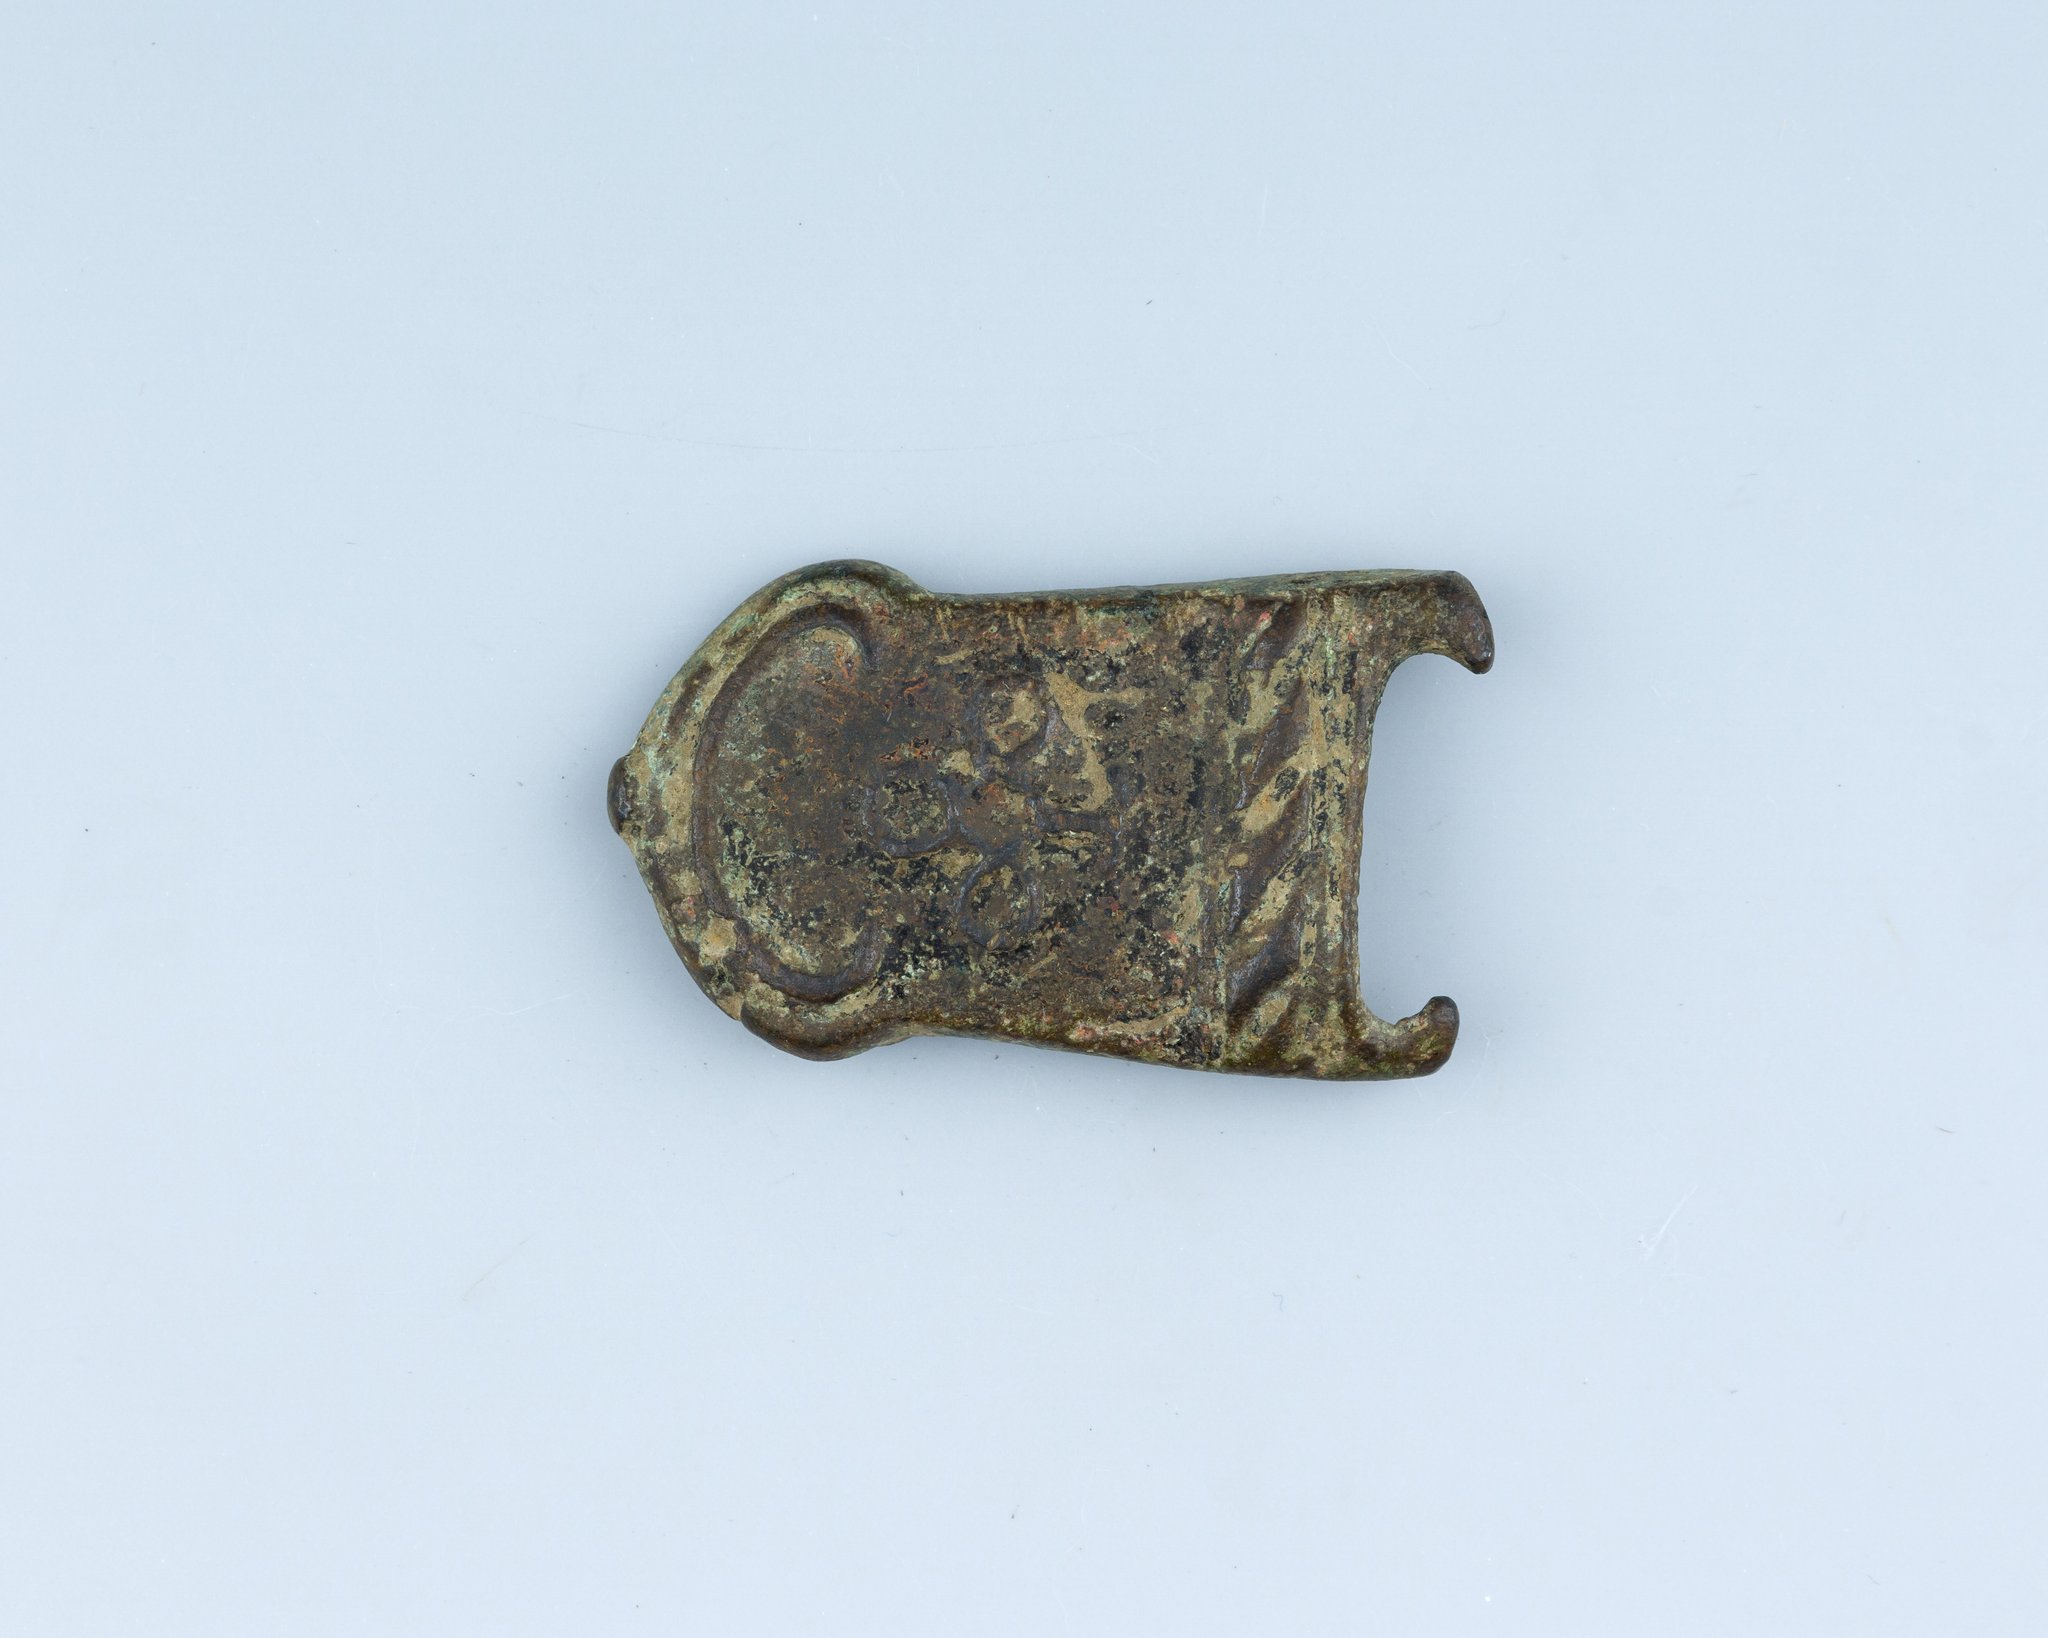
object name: mordant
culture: european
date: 1401-1700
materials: bronze